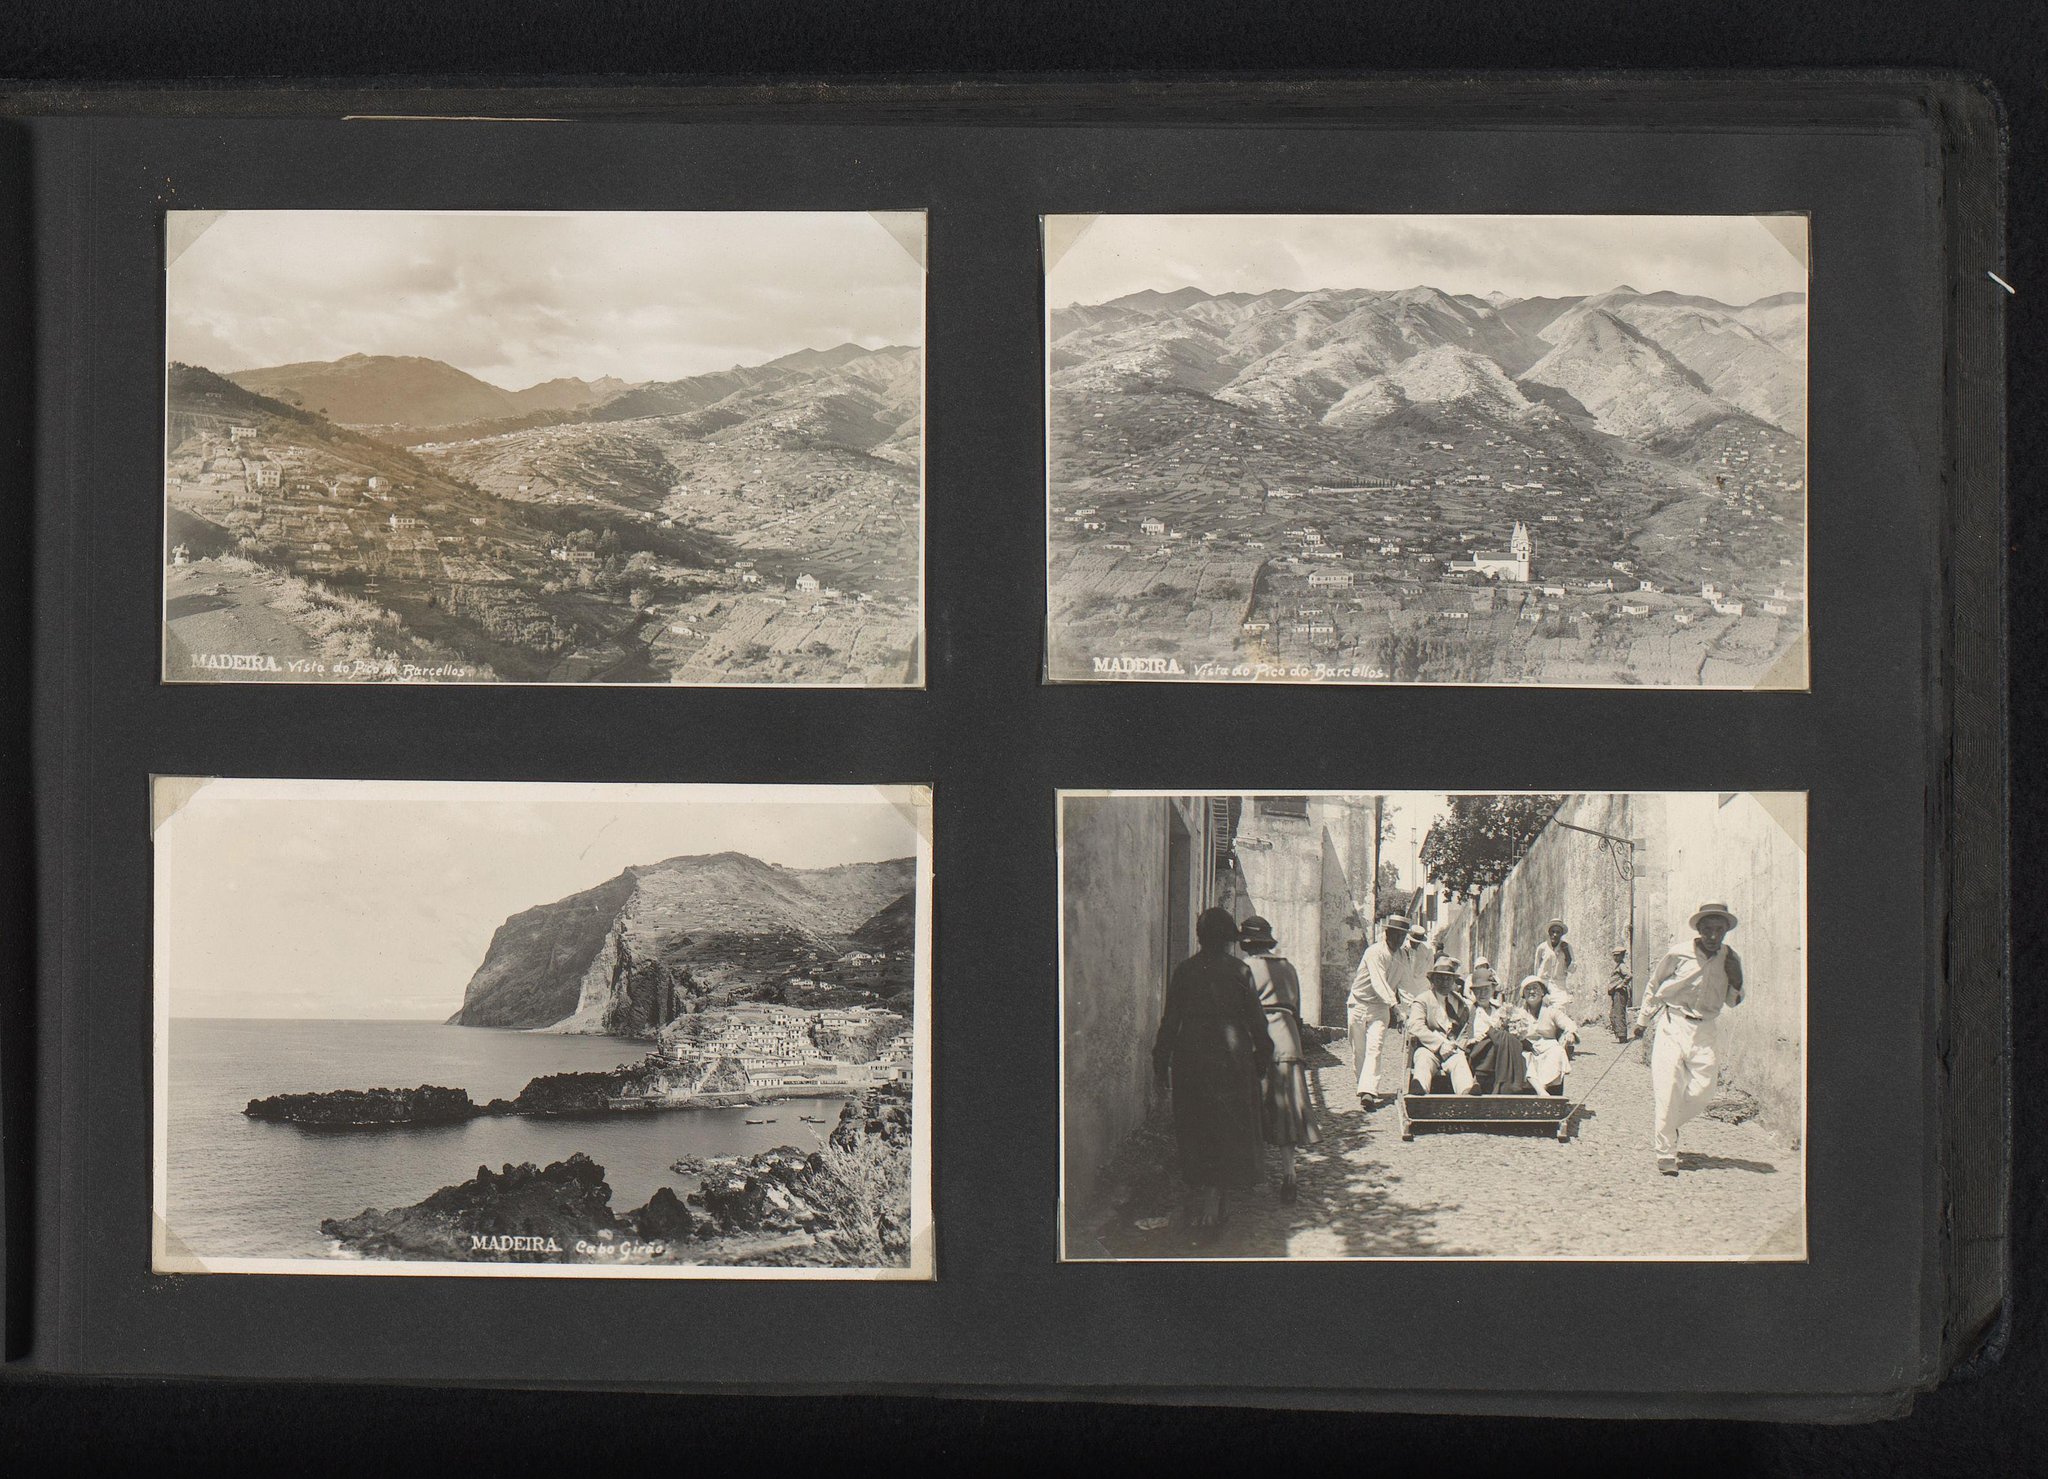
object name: photograph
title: Vier foto's, waarvan drie prentbriefkaarten, van Madeira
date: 1933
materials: paper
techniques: gelatin silver print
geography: madeira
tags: gulf, bay, city-view in general; 'veduta', carrying a person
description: Deze foto's maken deel uit van een album.